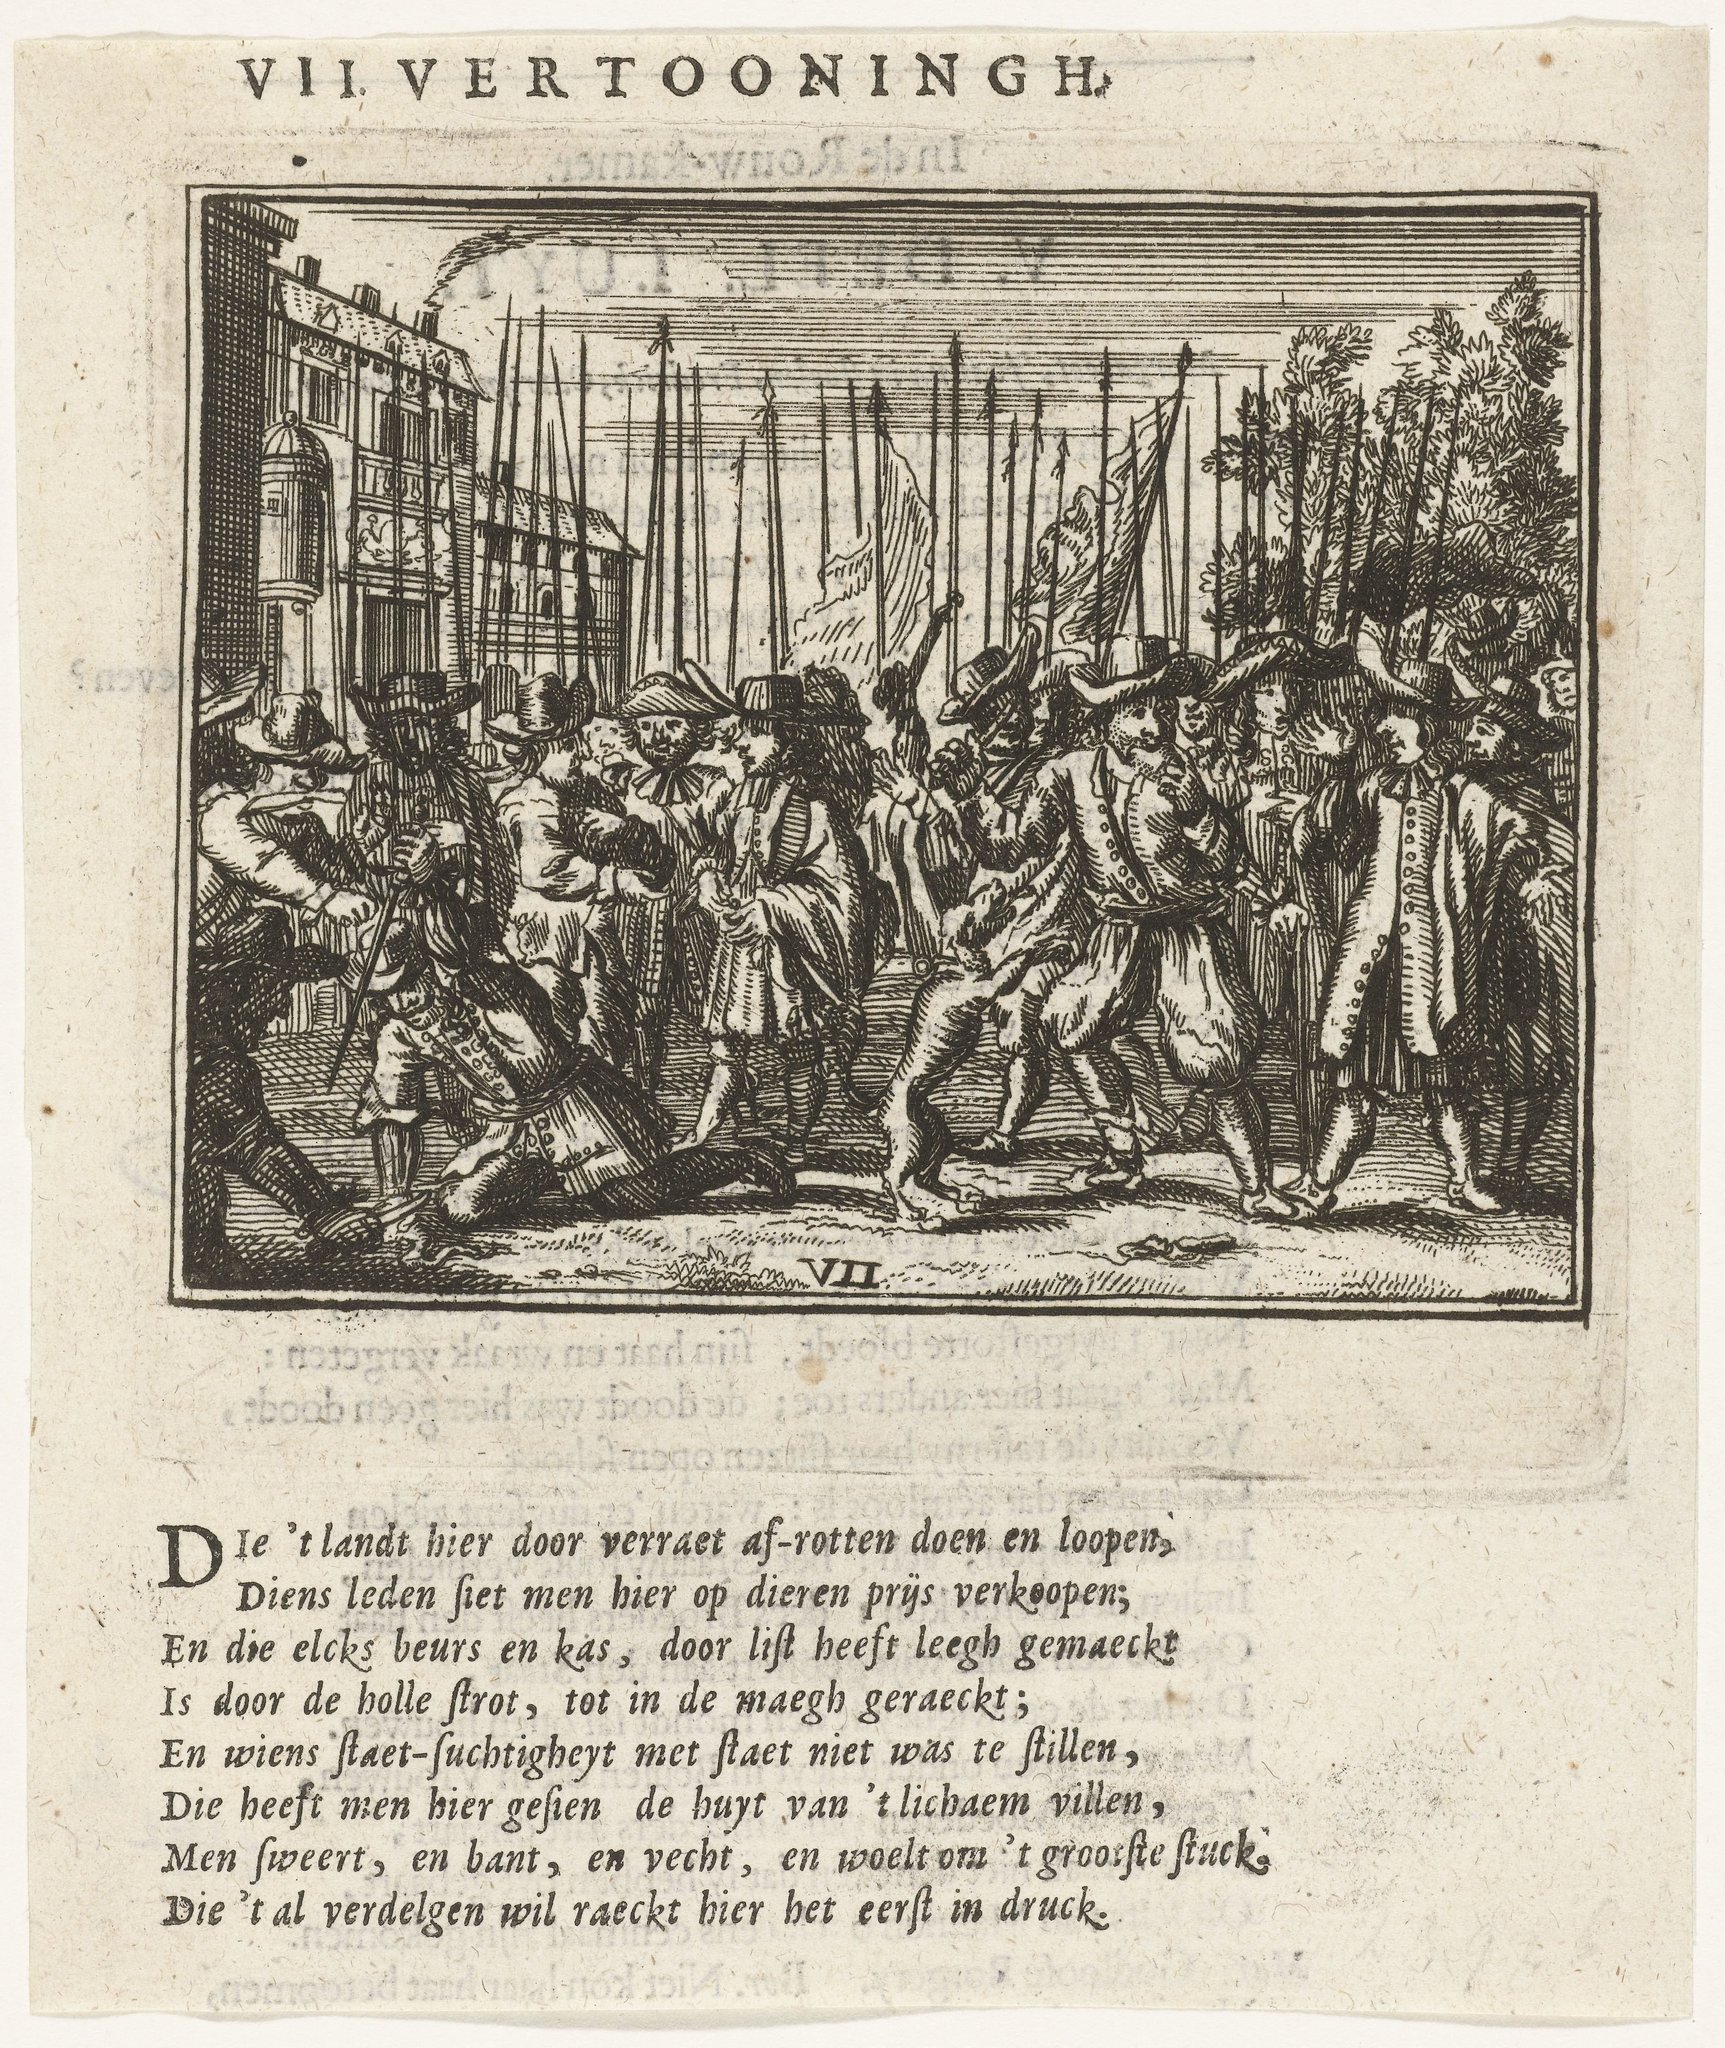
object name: book illustration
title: Delen van de lichamen worden verkocht, 1672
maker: Anonymous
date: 1672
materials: paper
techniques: etching, letterpress printing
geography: southern netherlands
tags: dordrecht, cornelis de witt, politician, johan de witt, mutilation of the corpse, cannibalism, the hague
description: Delen van de lichamen van de gebroeders de Witt worden verkocht en opgegeten, 20 augustus 1672. Scène uit het leven van Johan en Cornelis de Witt; onderdeel van een groep illustraties, genummerd: VII. Vertooningh en vergezeld van een vers van 8 regels. Bedrukt op achterzijde met tekst in het Nederlands.